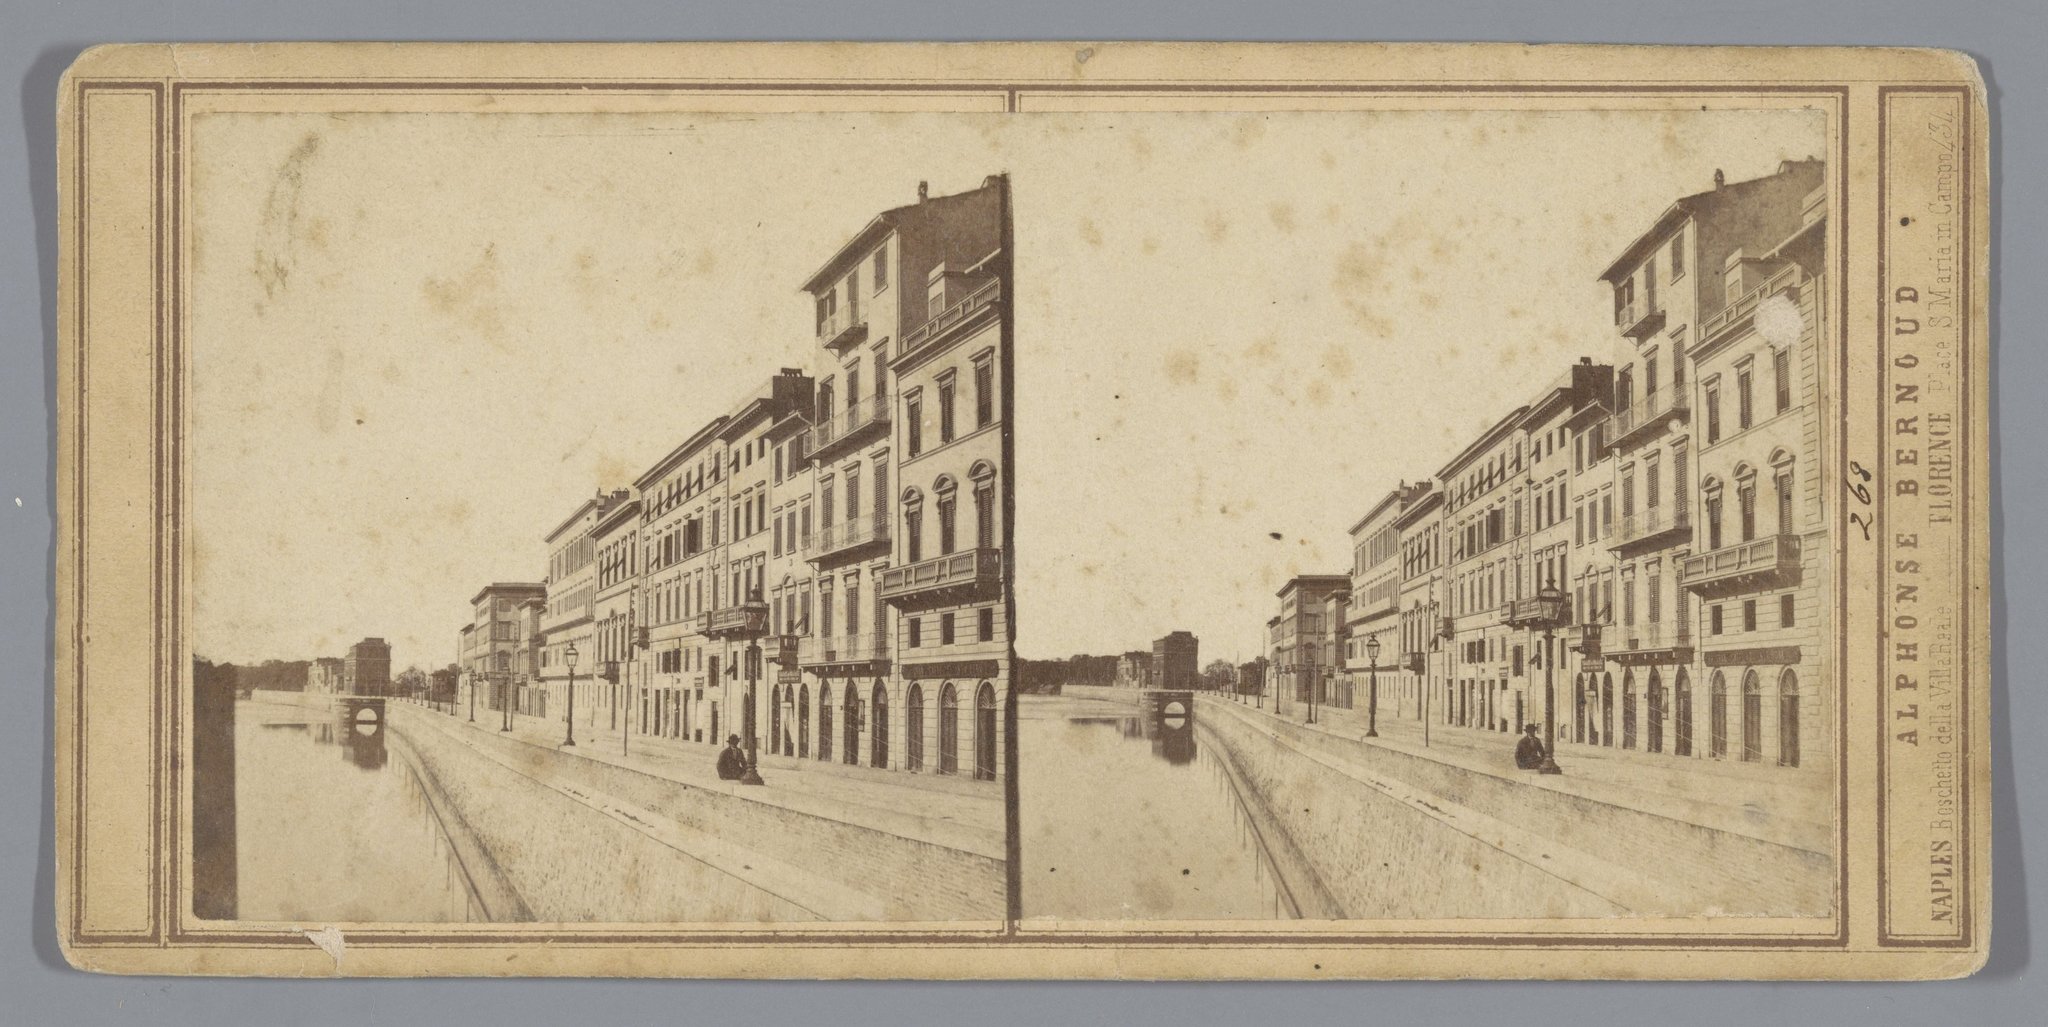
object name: stereograph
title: Gezicht op een kade (vermoedelijk) langs de Arno te Florence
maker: alphonse bernoud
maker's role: fotograaf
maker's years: 1820-1889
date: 1850-1880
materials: cardboard, photographic support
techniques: albumen print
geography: florence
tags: river, façade (of house or building), quay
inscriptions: name: ‘ALPHONSE BERNOUD NAPLES Boschetto della Villa Reale FLORENCE Place S. Maria in Campo 434.’, number: ‘268’